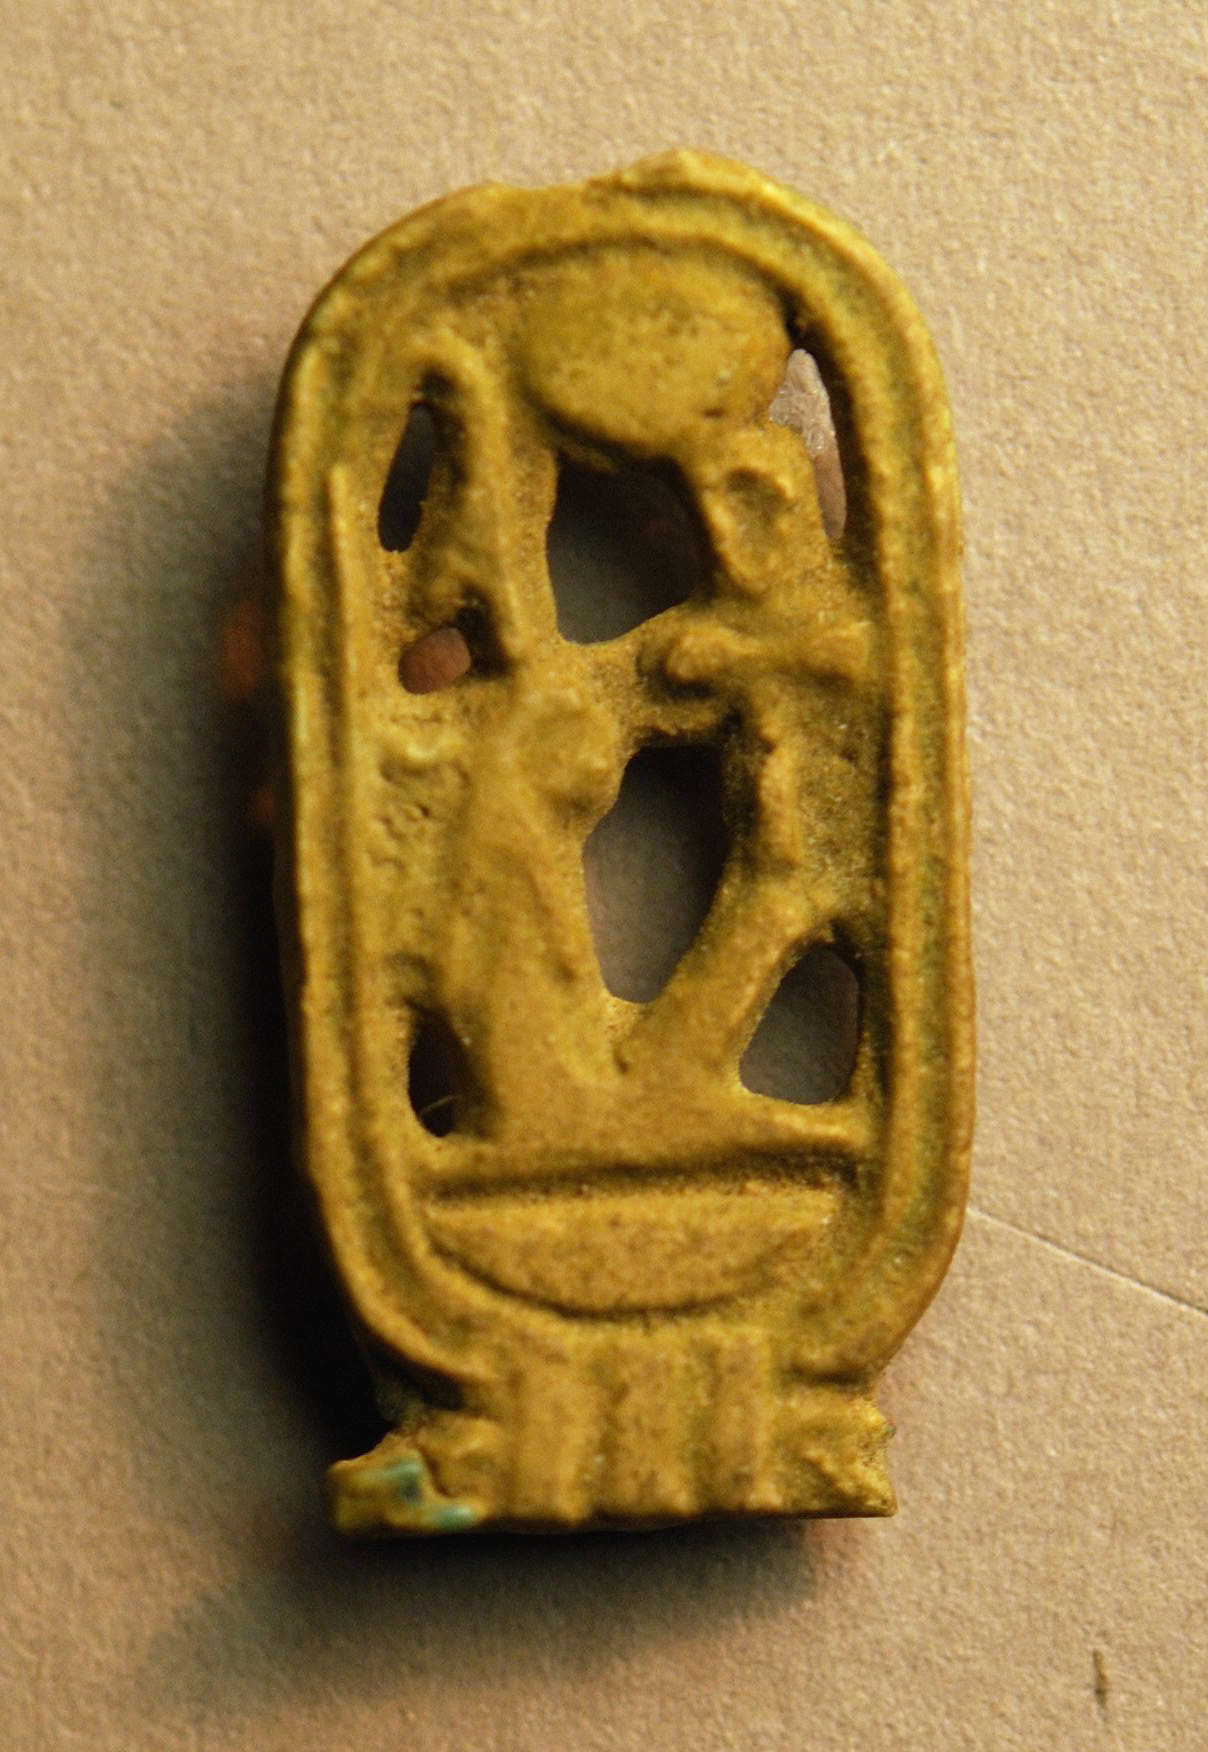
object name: amulet, cartouche, nebmaatre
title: Cartouche of Amenhotep III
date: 1390-1352 BCE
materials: faience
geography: egypt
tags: cartouches